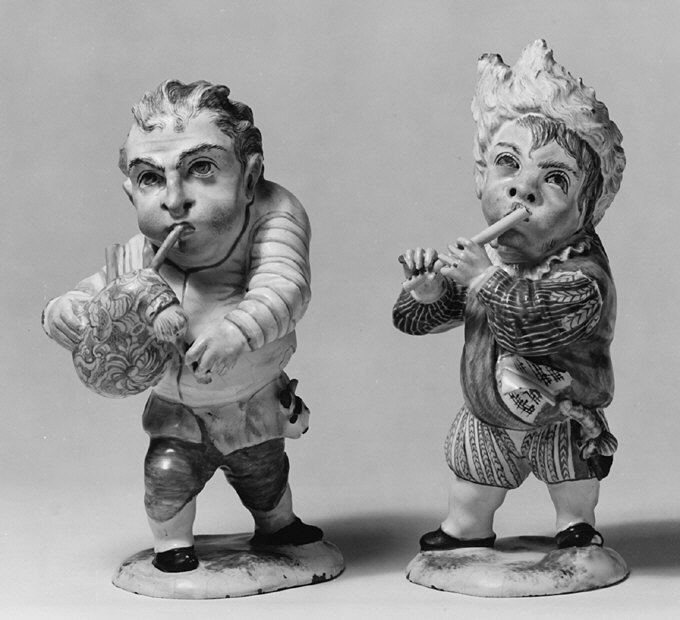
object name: figure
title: Dwarf musician (one of a pair)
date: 1750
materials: faience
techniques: glazing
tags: boys,flutes,musicians